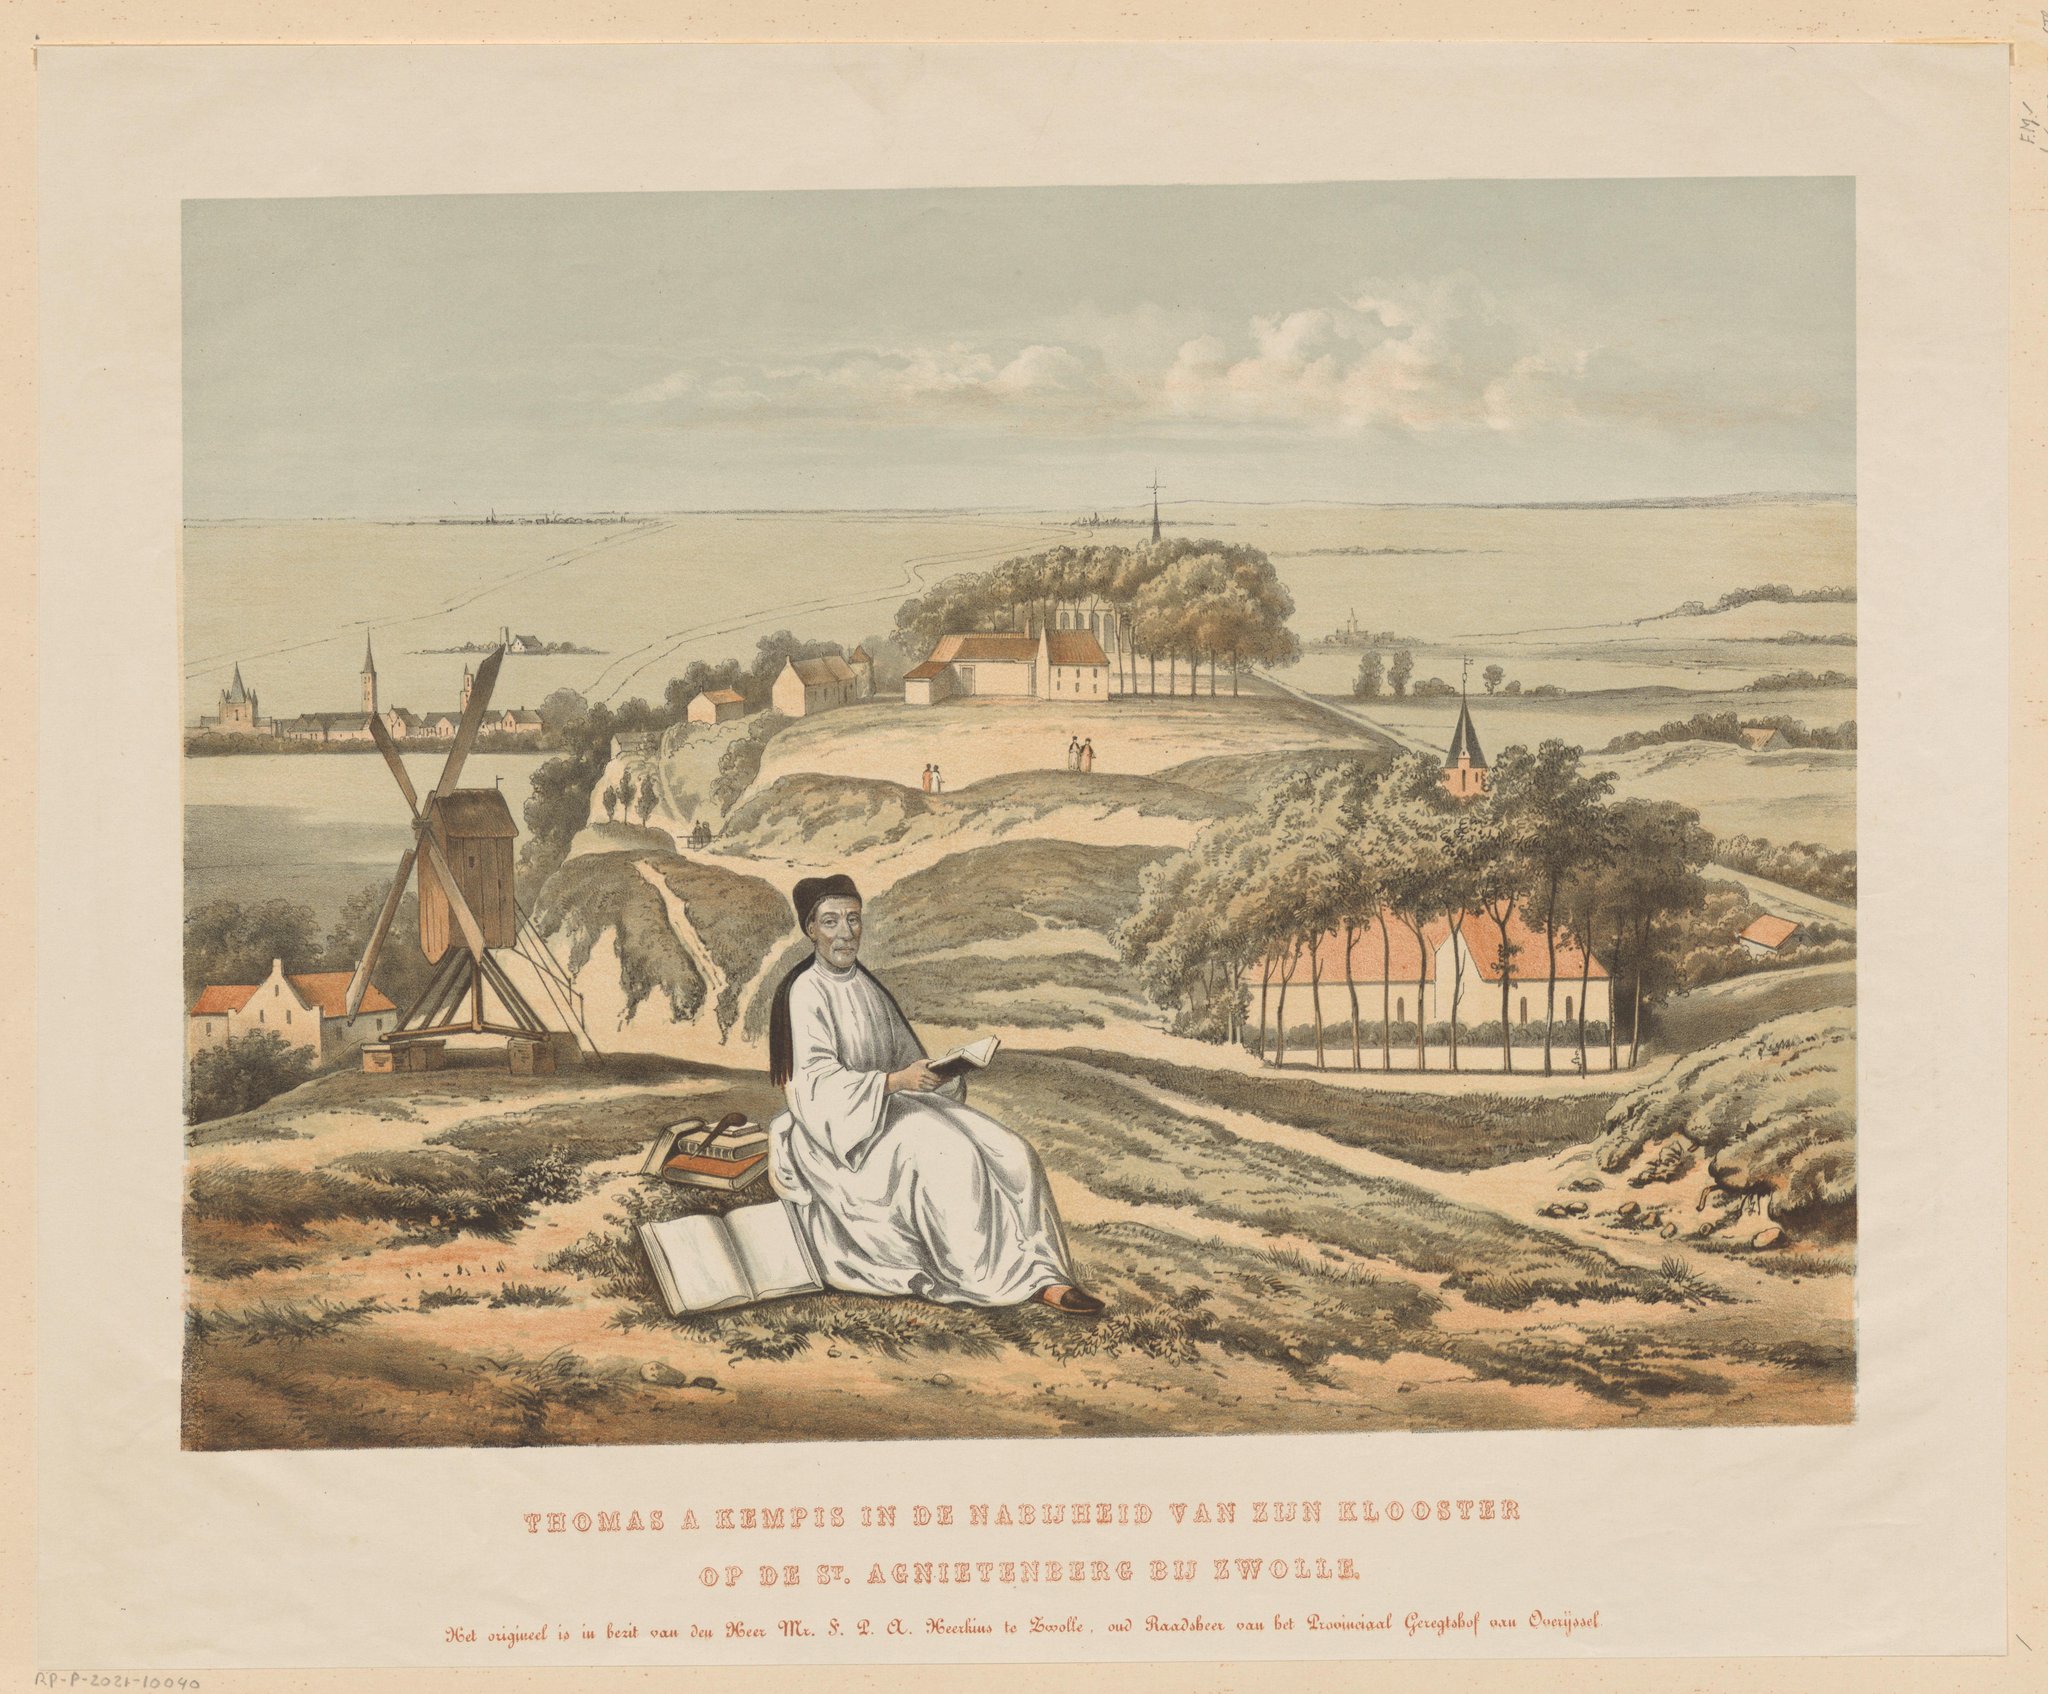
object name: print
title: Portret van Thomas à Kempis zittend in een landschap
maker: Anonymous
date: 1866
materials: paper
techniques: lithograph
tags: priest, thomas à kempis, landscapes, historical persons, monk(s), friar(s), windmill in landscape, organization, functionaries and dignitaries in churches and in related institutions, prospect of city, town panorama, silhouette of city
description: Prent opgevouwen gebruikt in: Bähring, Bernard. Thomas van Kempen, prediker van de navolging van Christus en zijne tijdgenooten. Amsterdam: H. Höveker, 1866.